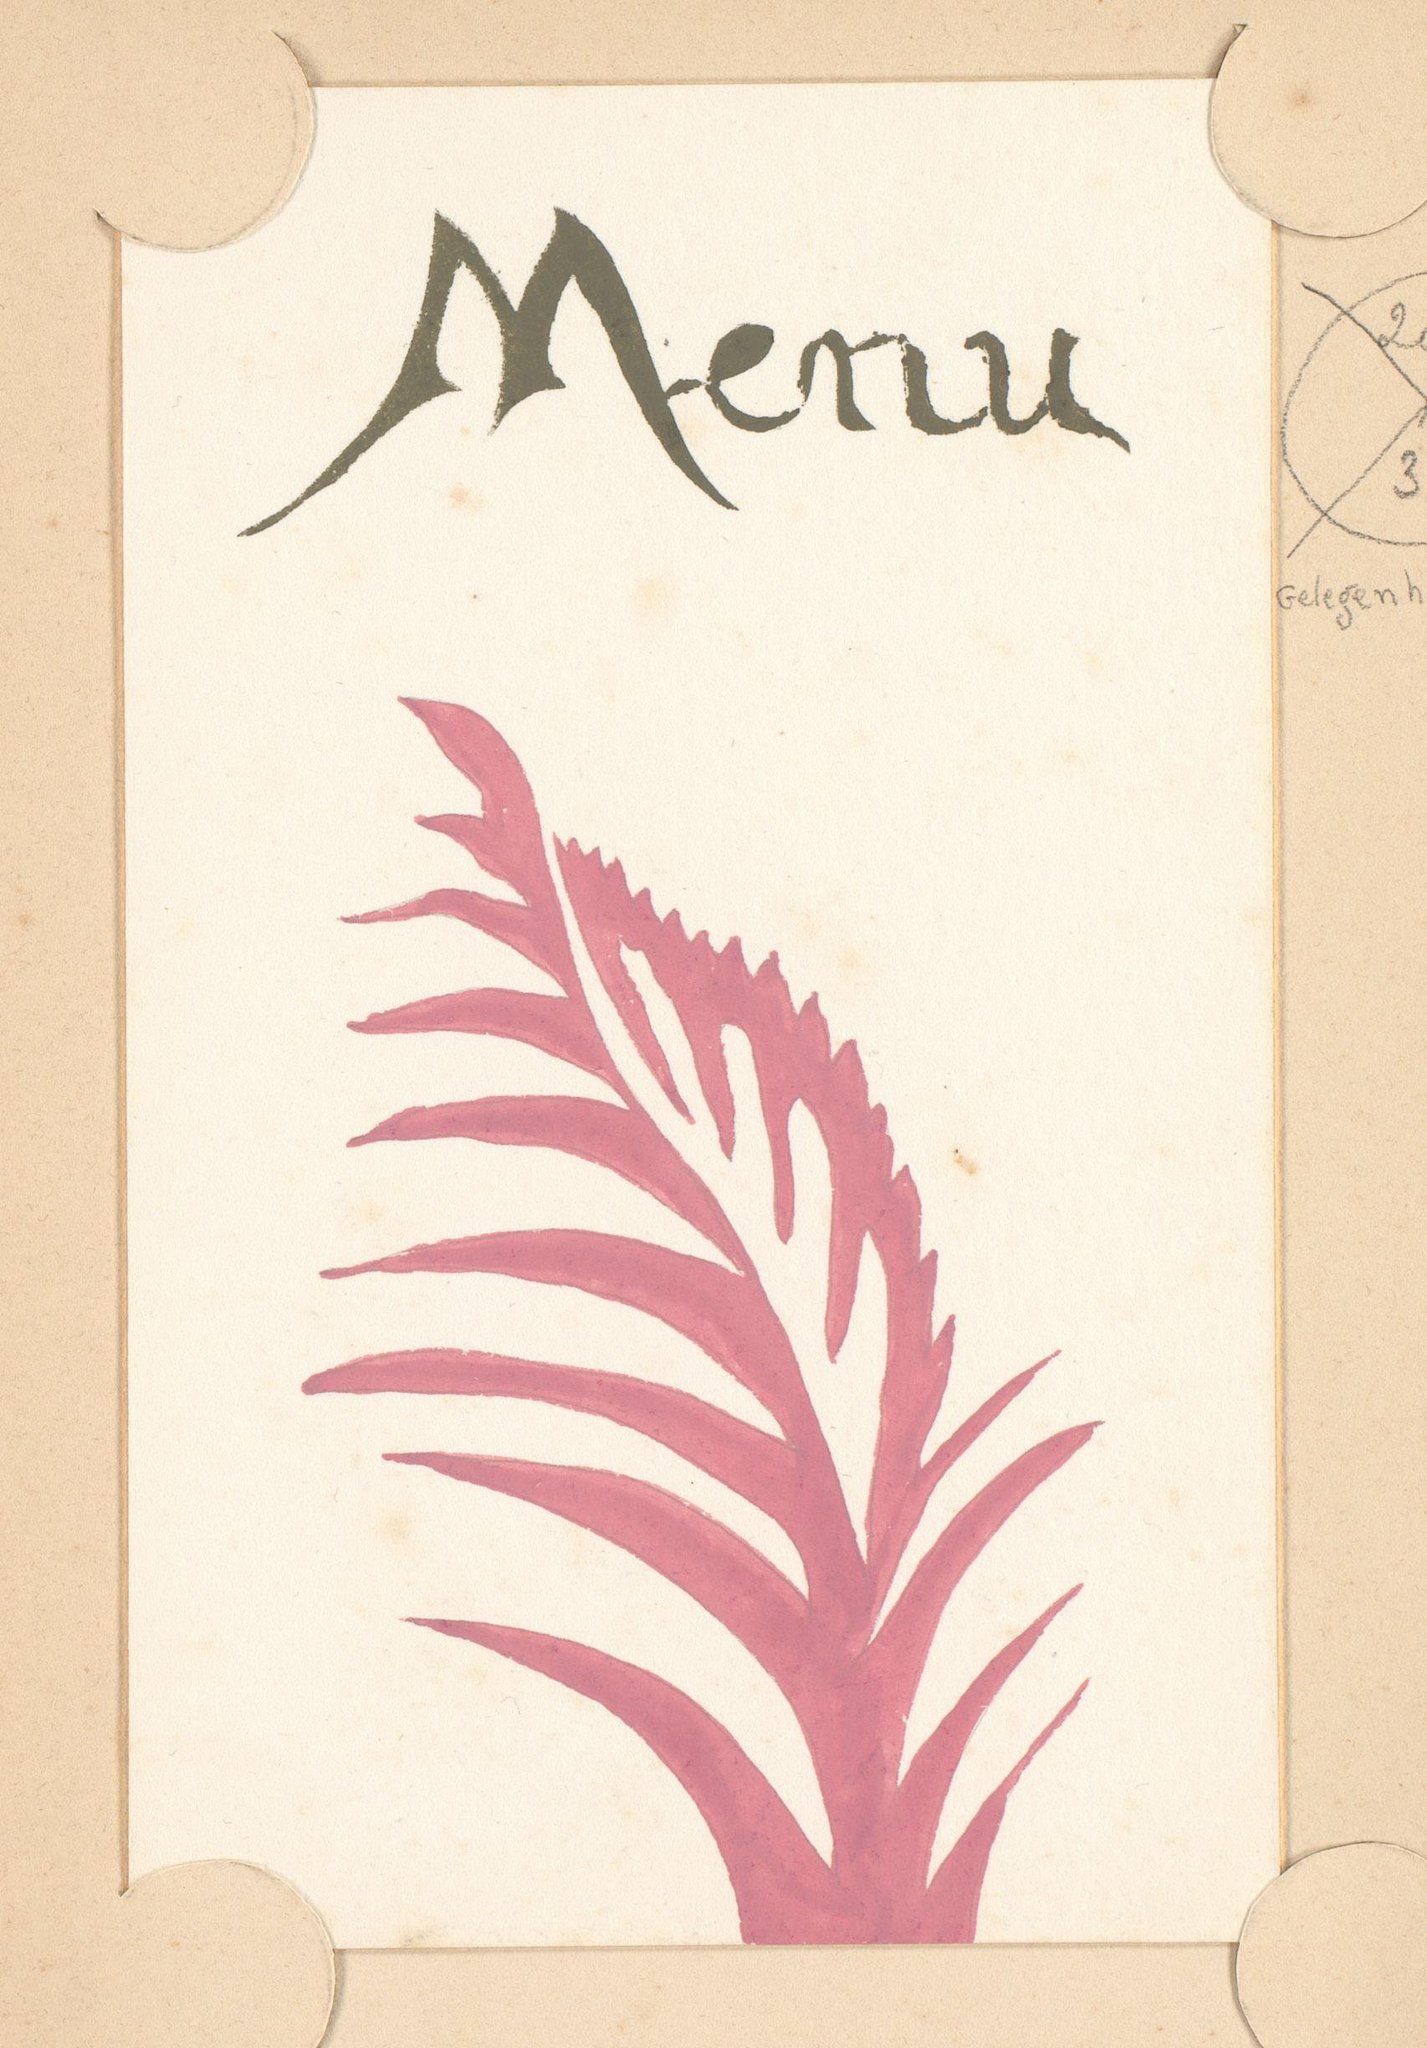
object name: album leaf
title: Menukaart met botanische decoratie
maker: theo colenbrander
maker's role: draughtsman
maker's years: 1841-1930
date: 1851-1930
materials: paper, pencil, paint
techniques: brush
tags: plants (in general)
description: Groot het woord 'Menu' met daaronder het silhouet van een plant. Deze tekening maakt deel uit van een album.